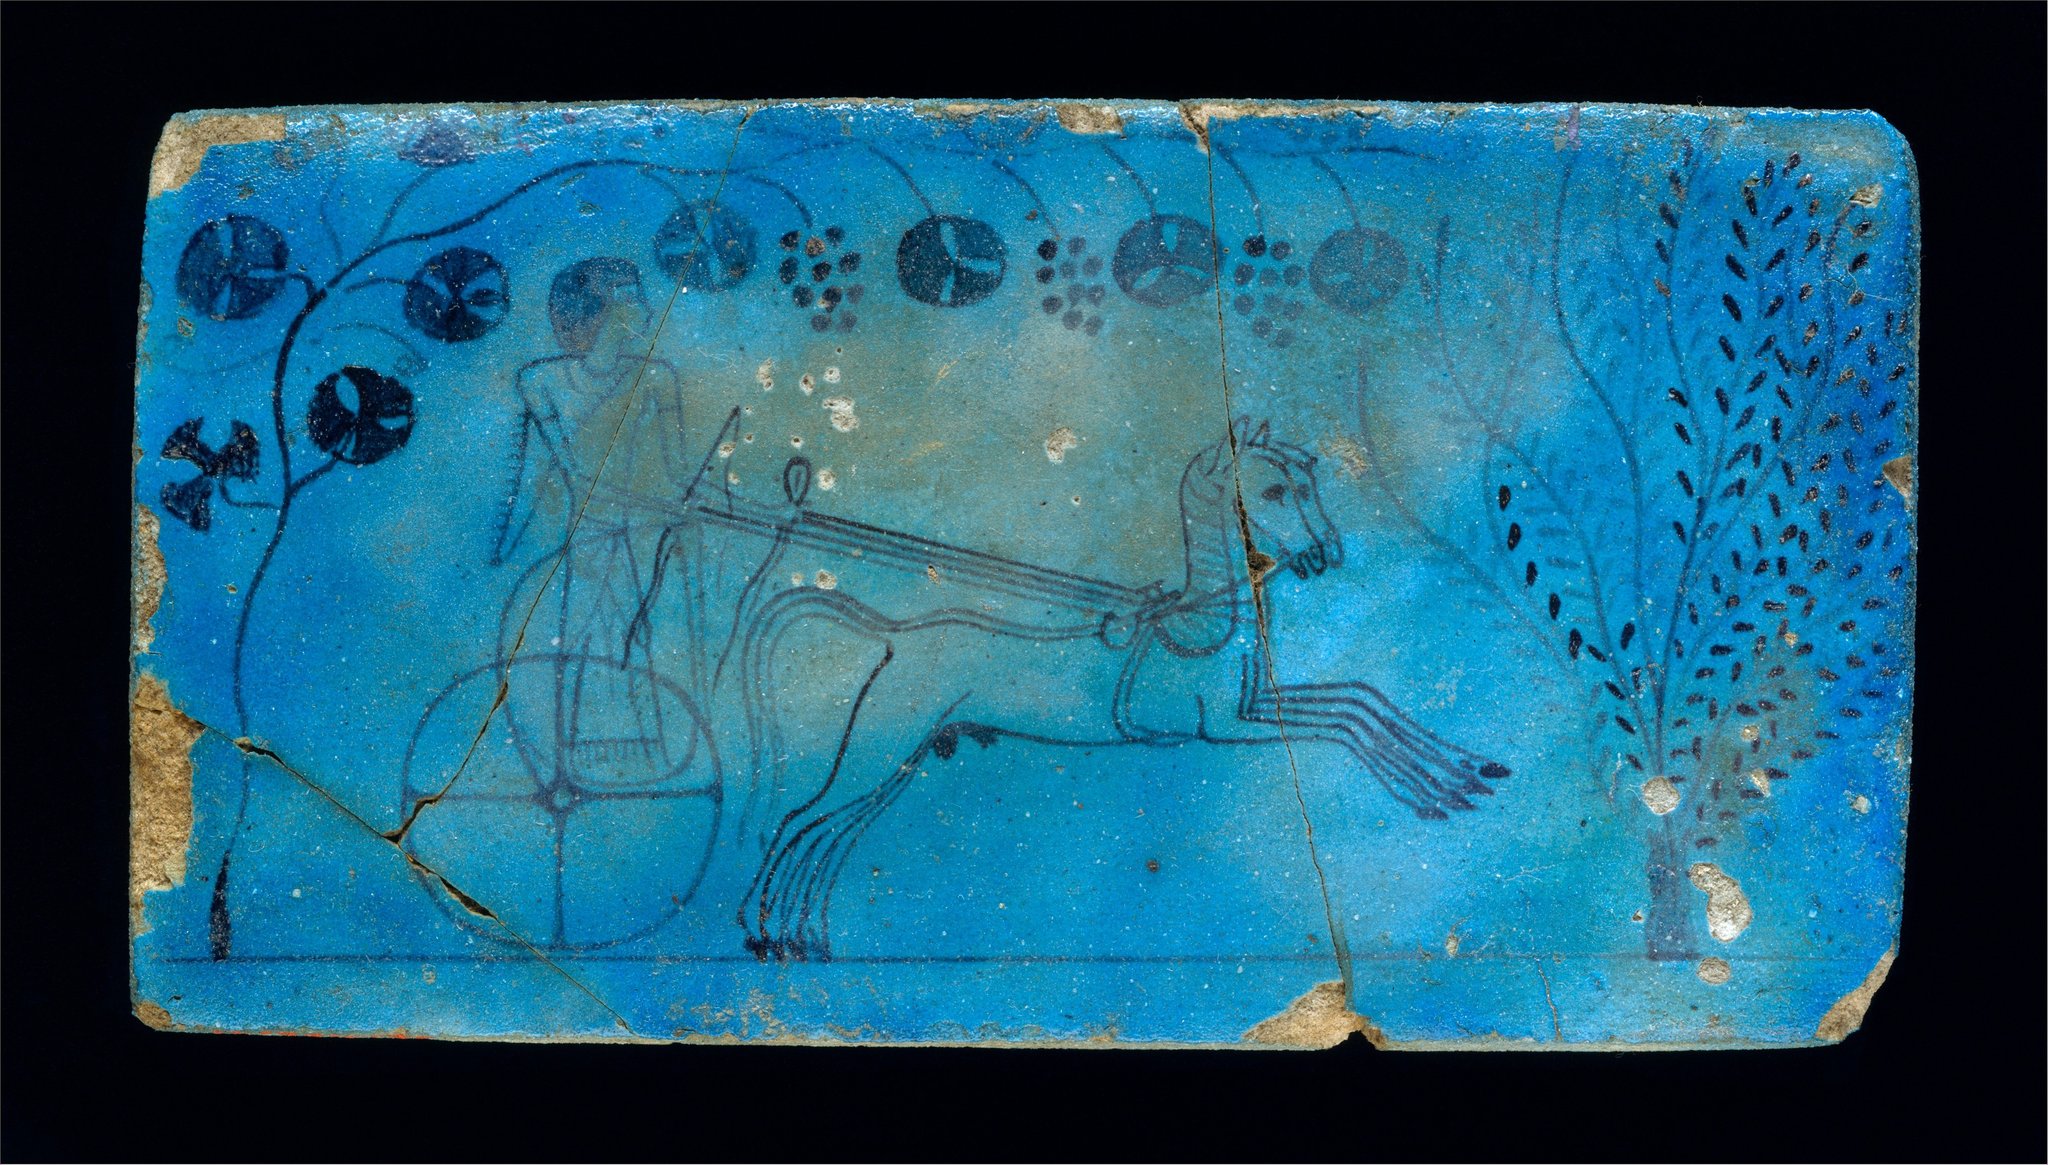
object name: tablet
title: Tablet with Chariot Scene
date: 1400-1390 BCE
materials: faience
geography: egypt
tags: men,horses,chariots